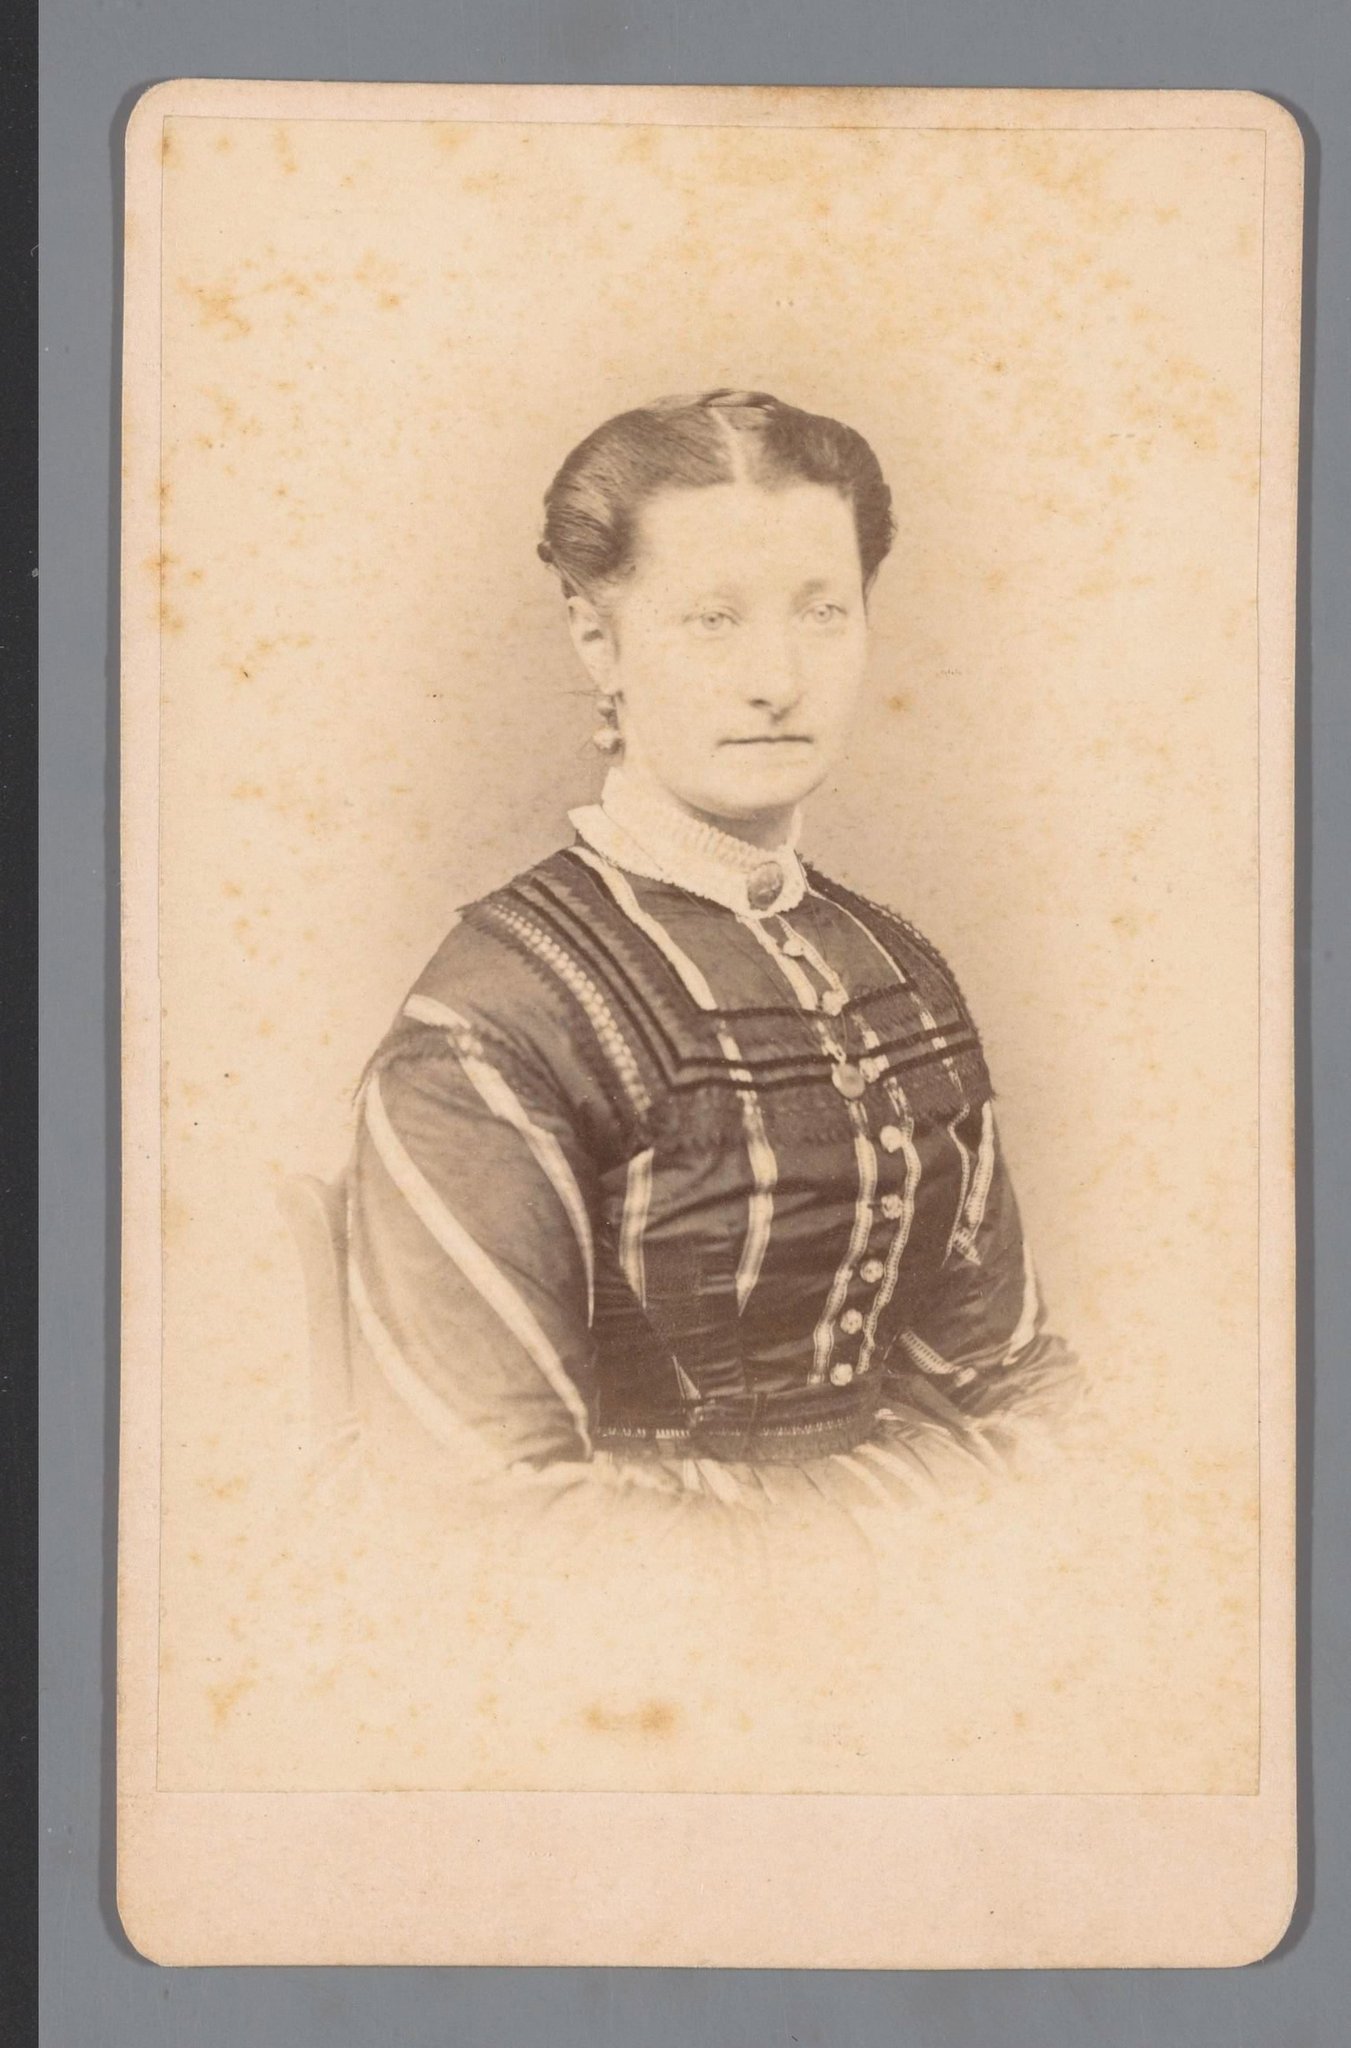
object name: photograph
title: Portret van een vrouw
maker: roelof lamberts elzinga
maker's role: fotograaf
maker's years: 1830-1908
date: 1865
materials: cardboard, paper, photographic support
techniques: albumen print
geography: sneek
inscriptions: address: ‘R: Elzinga/Phot. te Sneek’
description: Vrouw met grote oorbel, ten halven lijve, iets naar rechts.